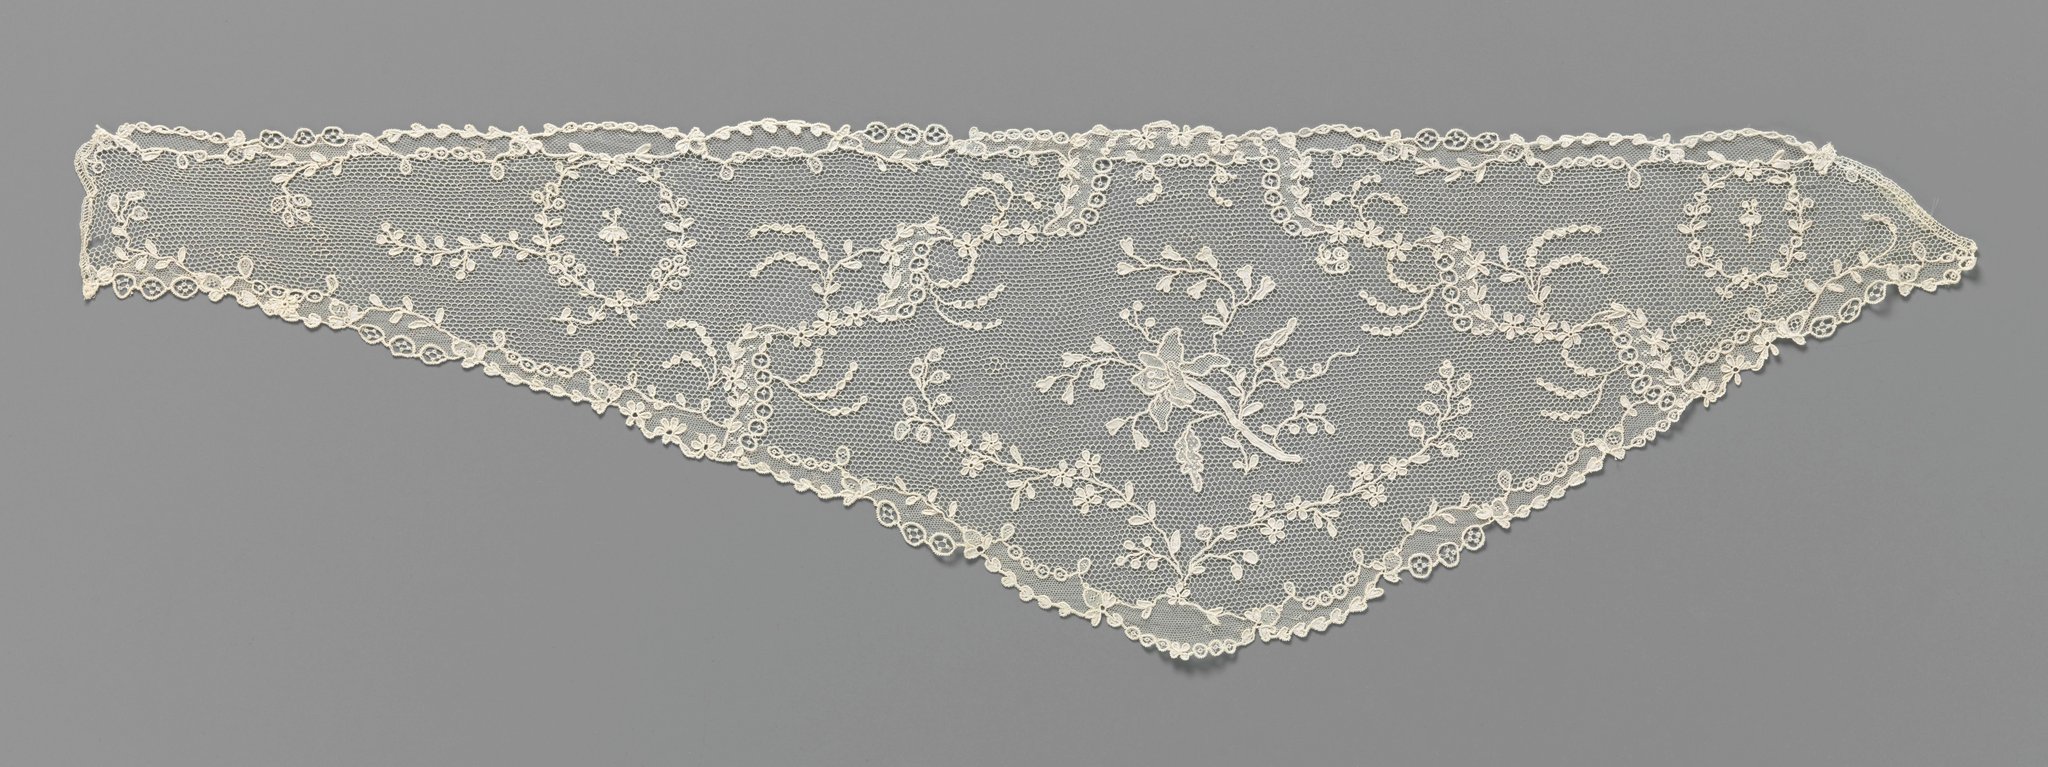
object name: engageante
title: Engageante van naaldkant met een a-symmetrische bloemtak in een symmetrische lijst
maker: Anonymous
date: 1775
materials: linen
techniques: lace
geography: france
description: Engageante van naturelkleurige naaldkant: Argentan-kant. Het patroon bestaat uit een a-symmetrische bloemtak in een symmetrische lijst. Onder de bloemtak twee lange takken die een v vormen. Aan weerszijden van de lijst staat een ovaal medaillon met een bloempje in het centrum. Met uitzondering van één grotere bloem in de centrale bloemtak bestaan de andere motieven uit dunne met picots bezette takken, met daaraan kleine blaadjes, bloempjes, trosjes bessen en 'snoeren' van opengewerkte en gepicoteerde cirkeltjes. De motieven zijn opgebouwd uit festonsteken en voorzien van reliëfcontouren. De motieven zijn met elkaar verbonden door een grond met mazen die dicht omnaaid zijn met festonsteken, een Argentan-grond. Siergrondjes en siersteken zijn toegepast in verschillende blaadjes, cirkeltjes en in de bloembladeren van de centrale bloem. Langs de randen zijn aaneengeschakelde langwerpige veldjes gevuld met een fijnere maasgrond, de veldjes worden afgebakend door bladertakjes, hartvormige blaadjes en cirkeltjes.